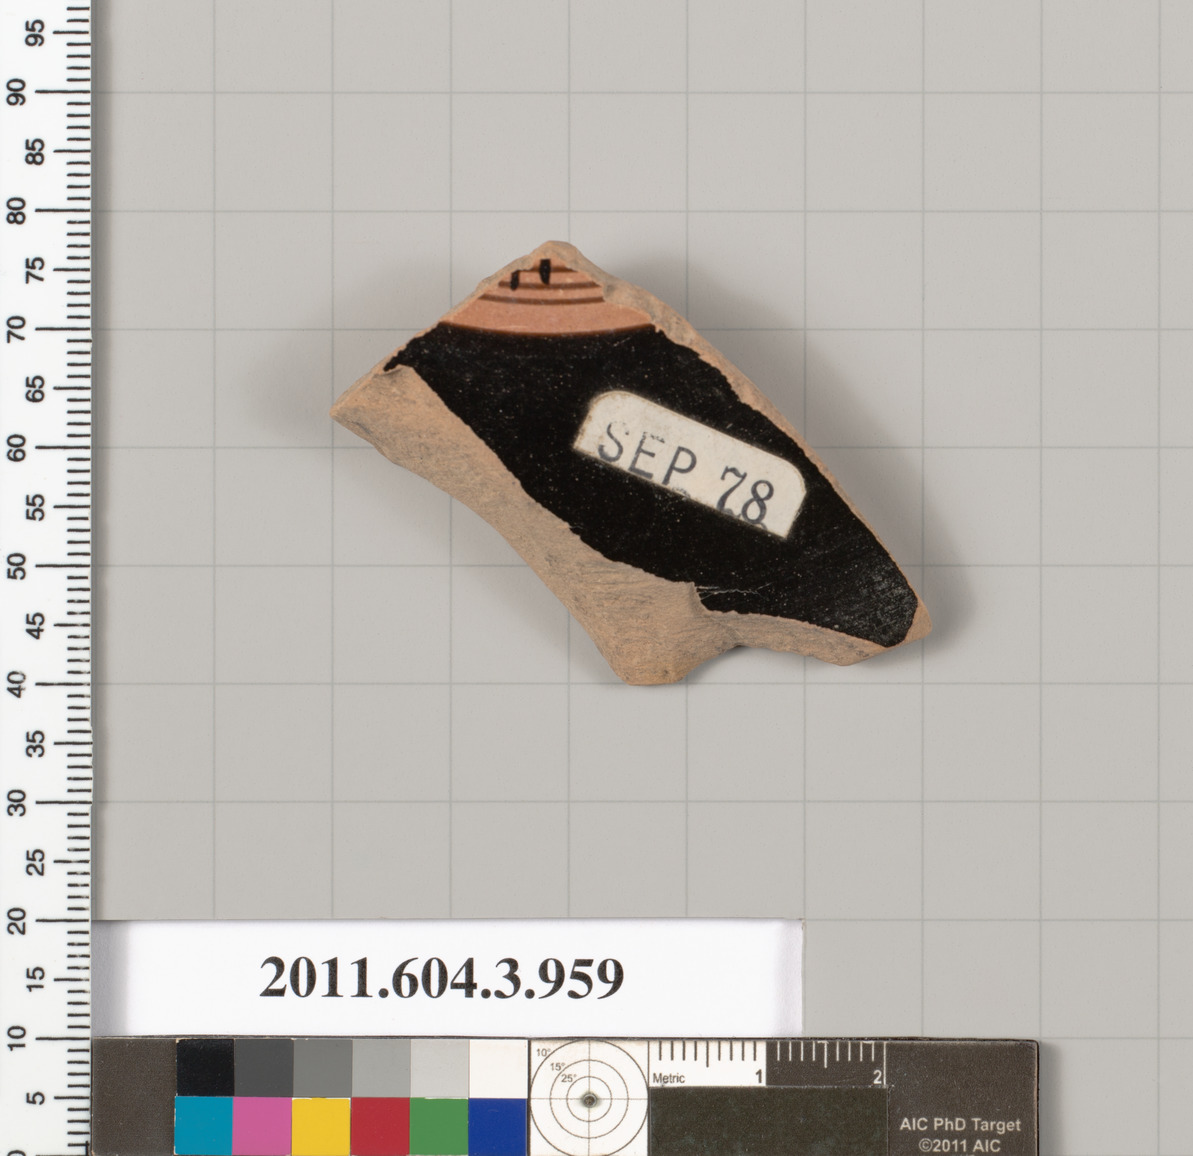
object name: lekanis lid fragment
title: Terracotta fragment of a lekanis lid (covered dish)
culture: greek, attic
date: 600-501 BCE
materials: terracotta